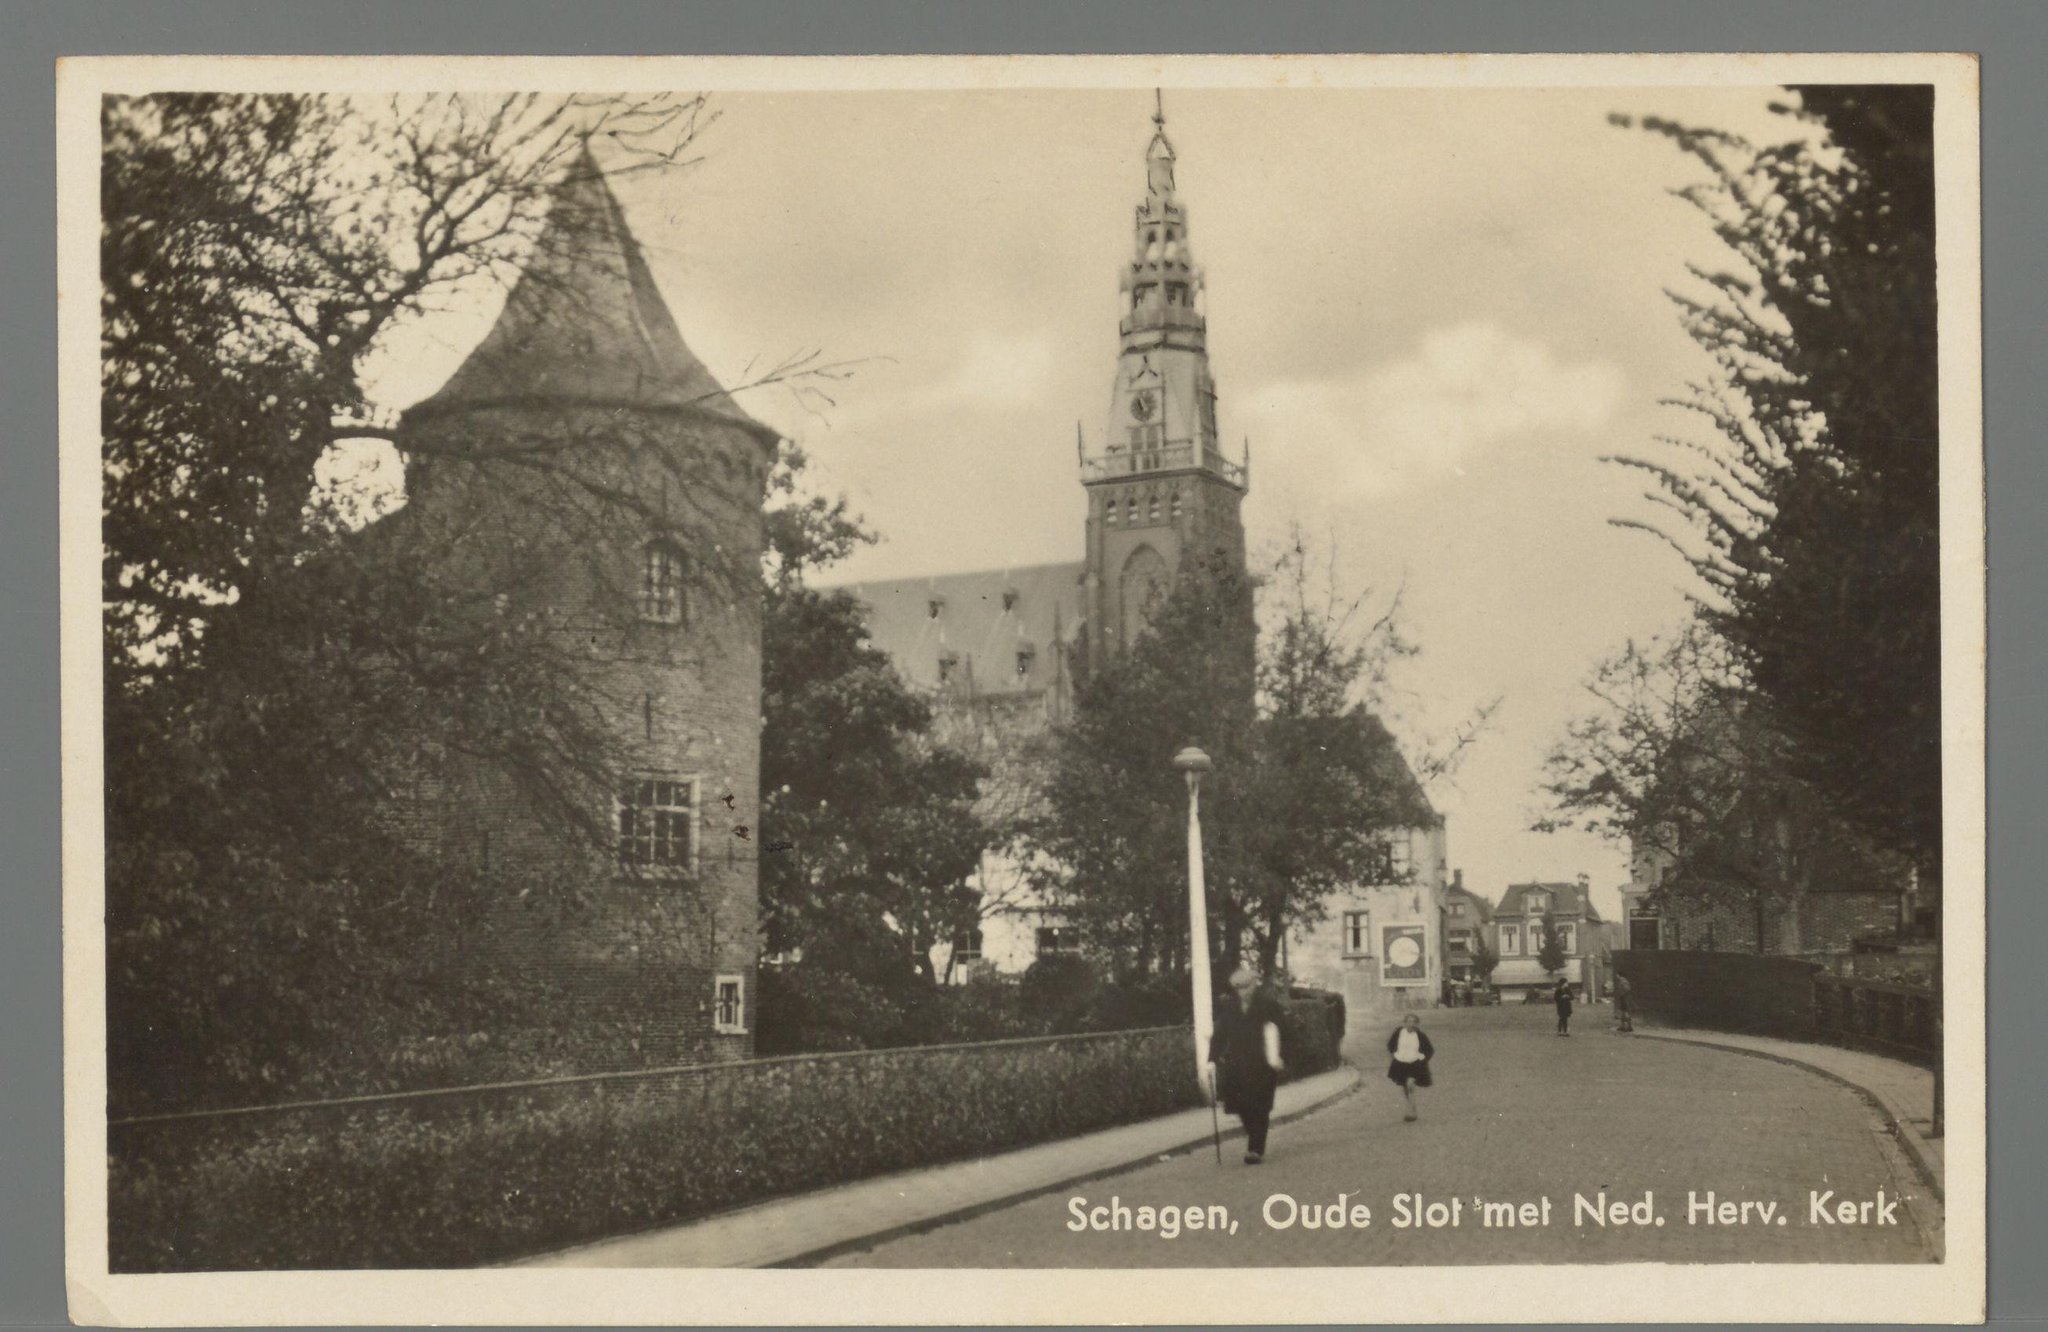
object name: ansichtkaart, prentbriefkaart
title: Schagen, Oude Slot met Ned. Herv. Kerk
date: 1929-1941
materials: photographic support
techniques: photography, writing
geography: schagen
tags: city-view, and landscape with man-made constructions, castle, church (exterior), schagen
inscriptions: postage stamp